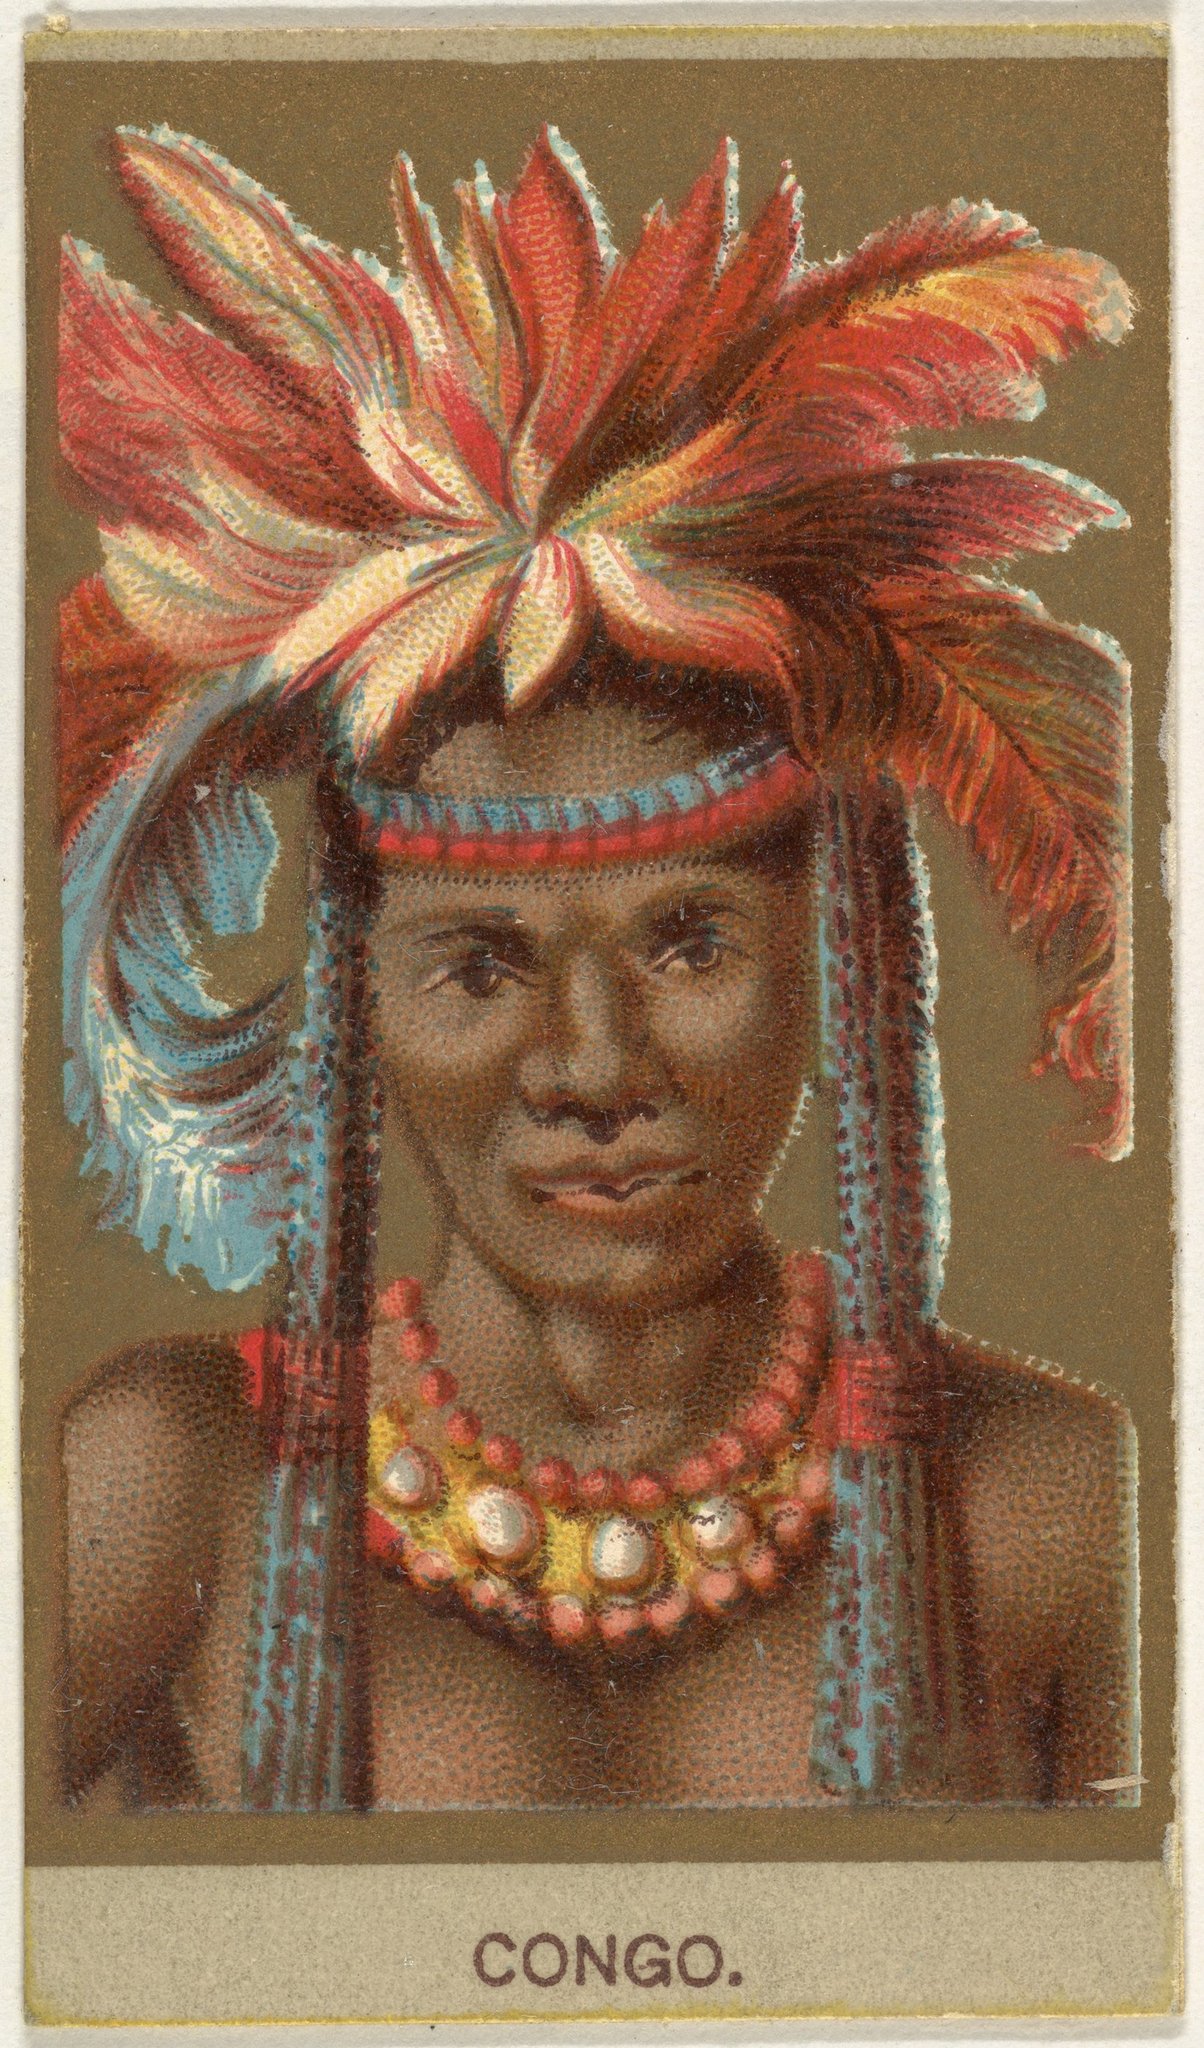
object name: print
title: Congo, from the Races of Mankind series (T181) issued by Abdul Cigarettes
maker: abdul cigarettes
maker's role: publisher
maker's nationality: american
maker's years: 1881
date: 1881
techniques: color lithograph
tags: men